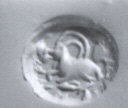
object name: stamp seal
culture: sasanian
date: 401-700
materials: gemstone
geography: iran